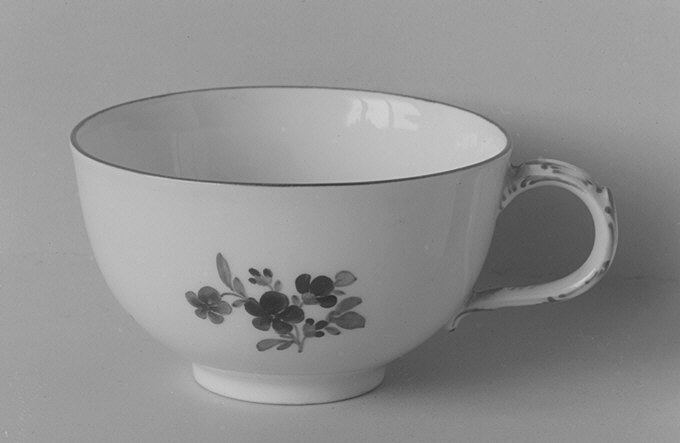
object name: cup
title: Cup (part of a set)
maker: royal porcelain manufactory, berlin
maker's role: manufactory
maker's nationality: german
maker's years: 1763-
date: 1765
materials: hard paste porcelain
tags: flowers